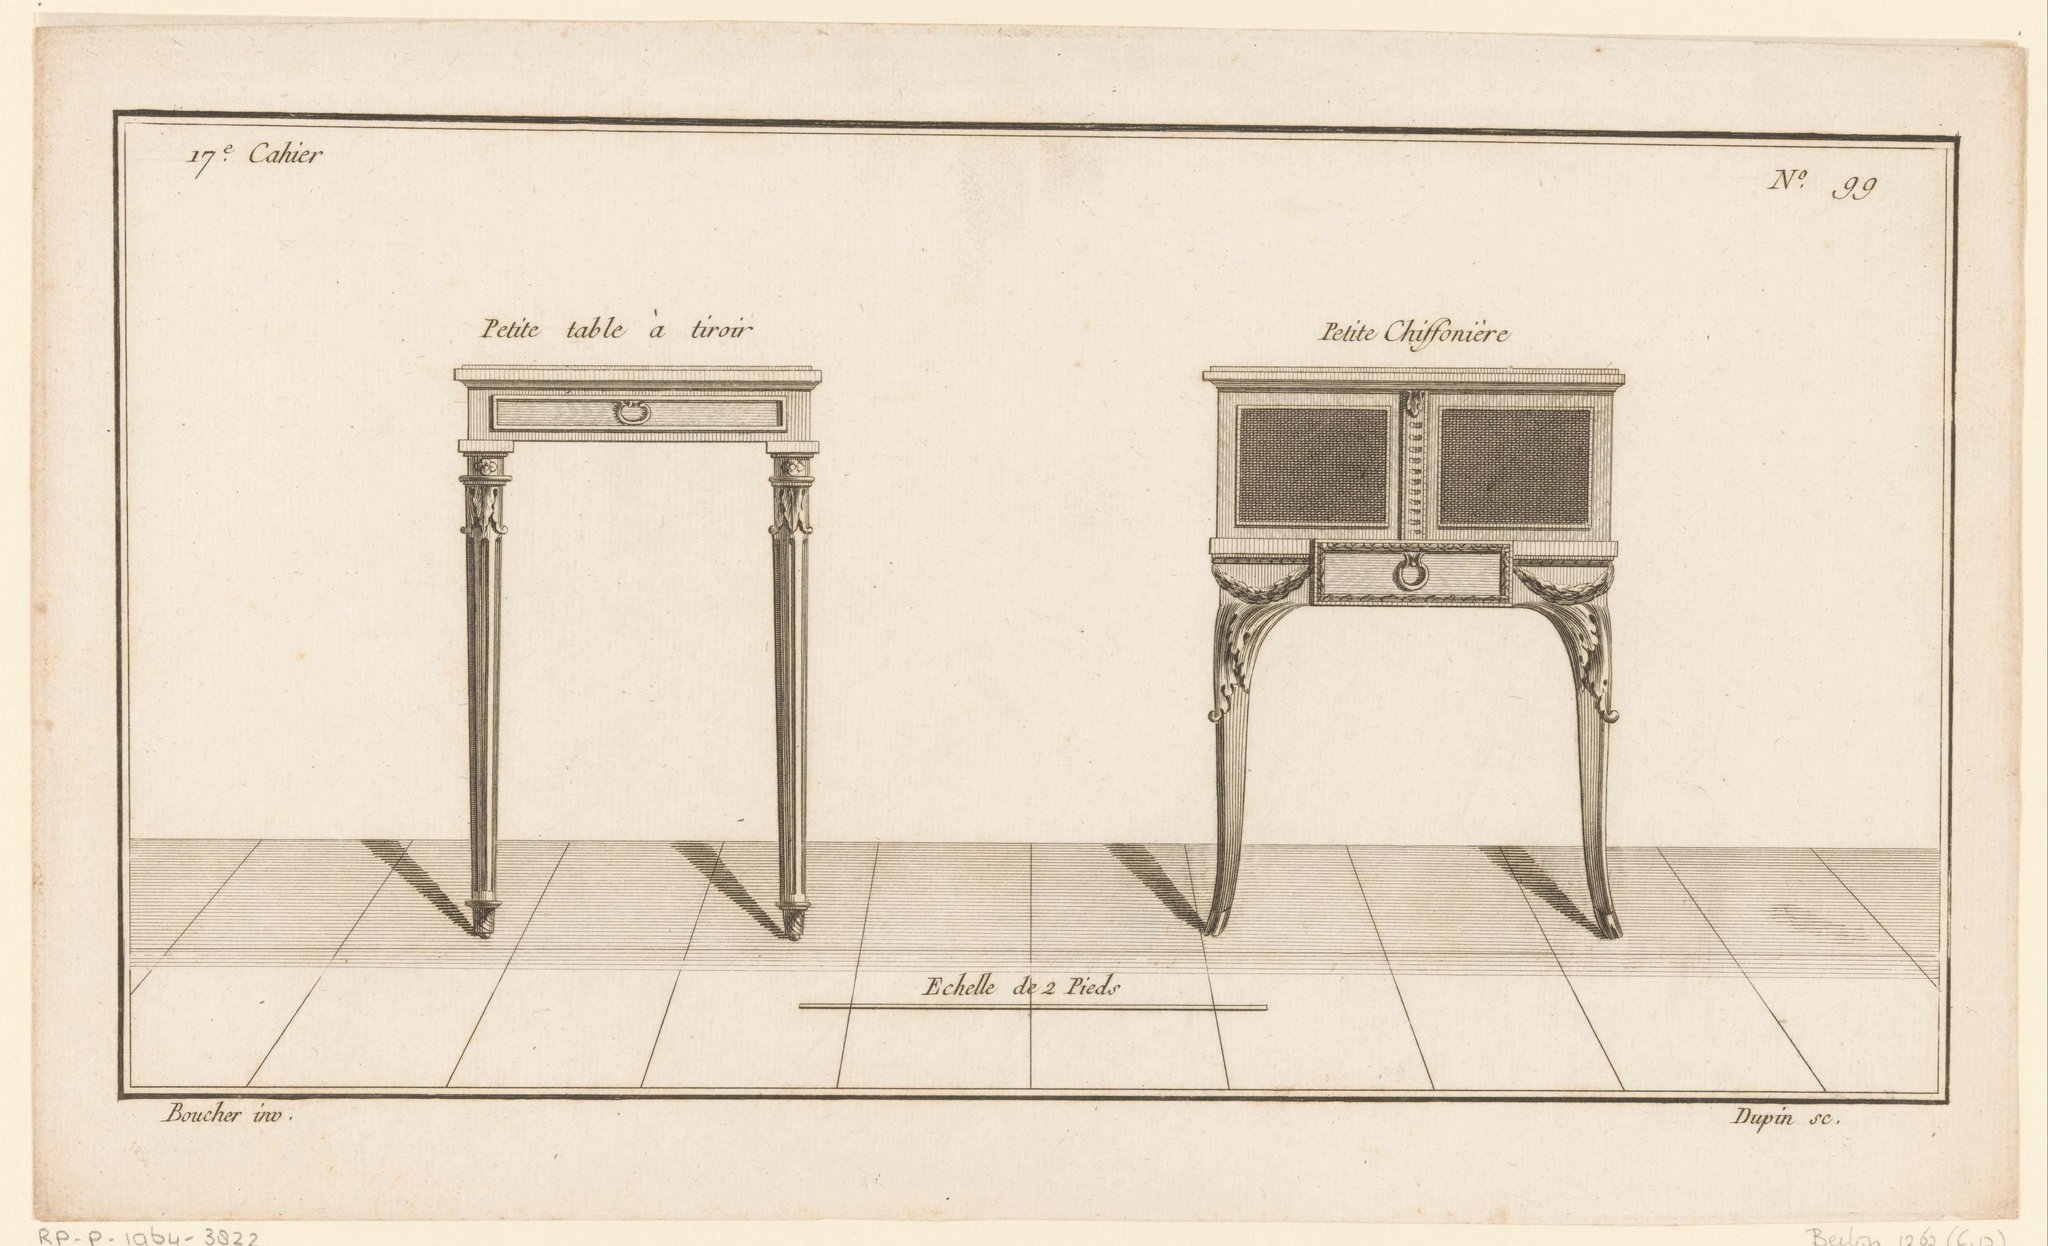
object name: ornament print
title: Tafel en chiffoniere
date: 1772-1779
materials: paper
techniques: engraving, etching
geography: paris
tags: table, furniture to put things on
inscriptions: collector's mark: Lugt 2760, collector's mark: Lugt 2228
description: Links een geornamenteerde tafel met een lade en rechts een geornamenteerde chiffoniere. Prentnummer 99.